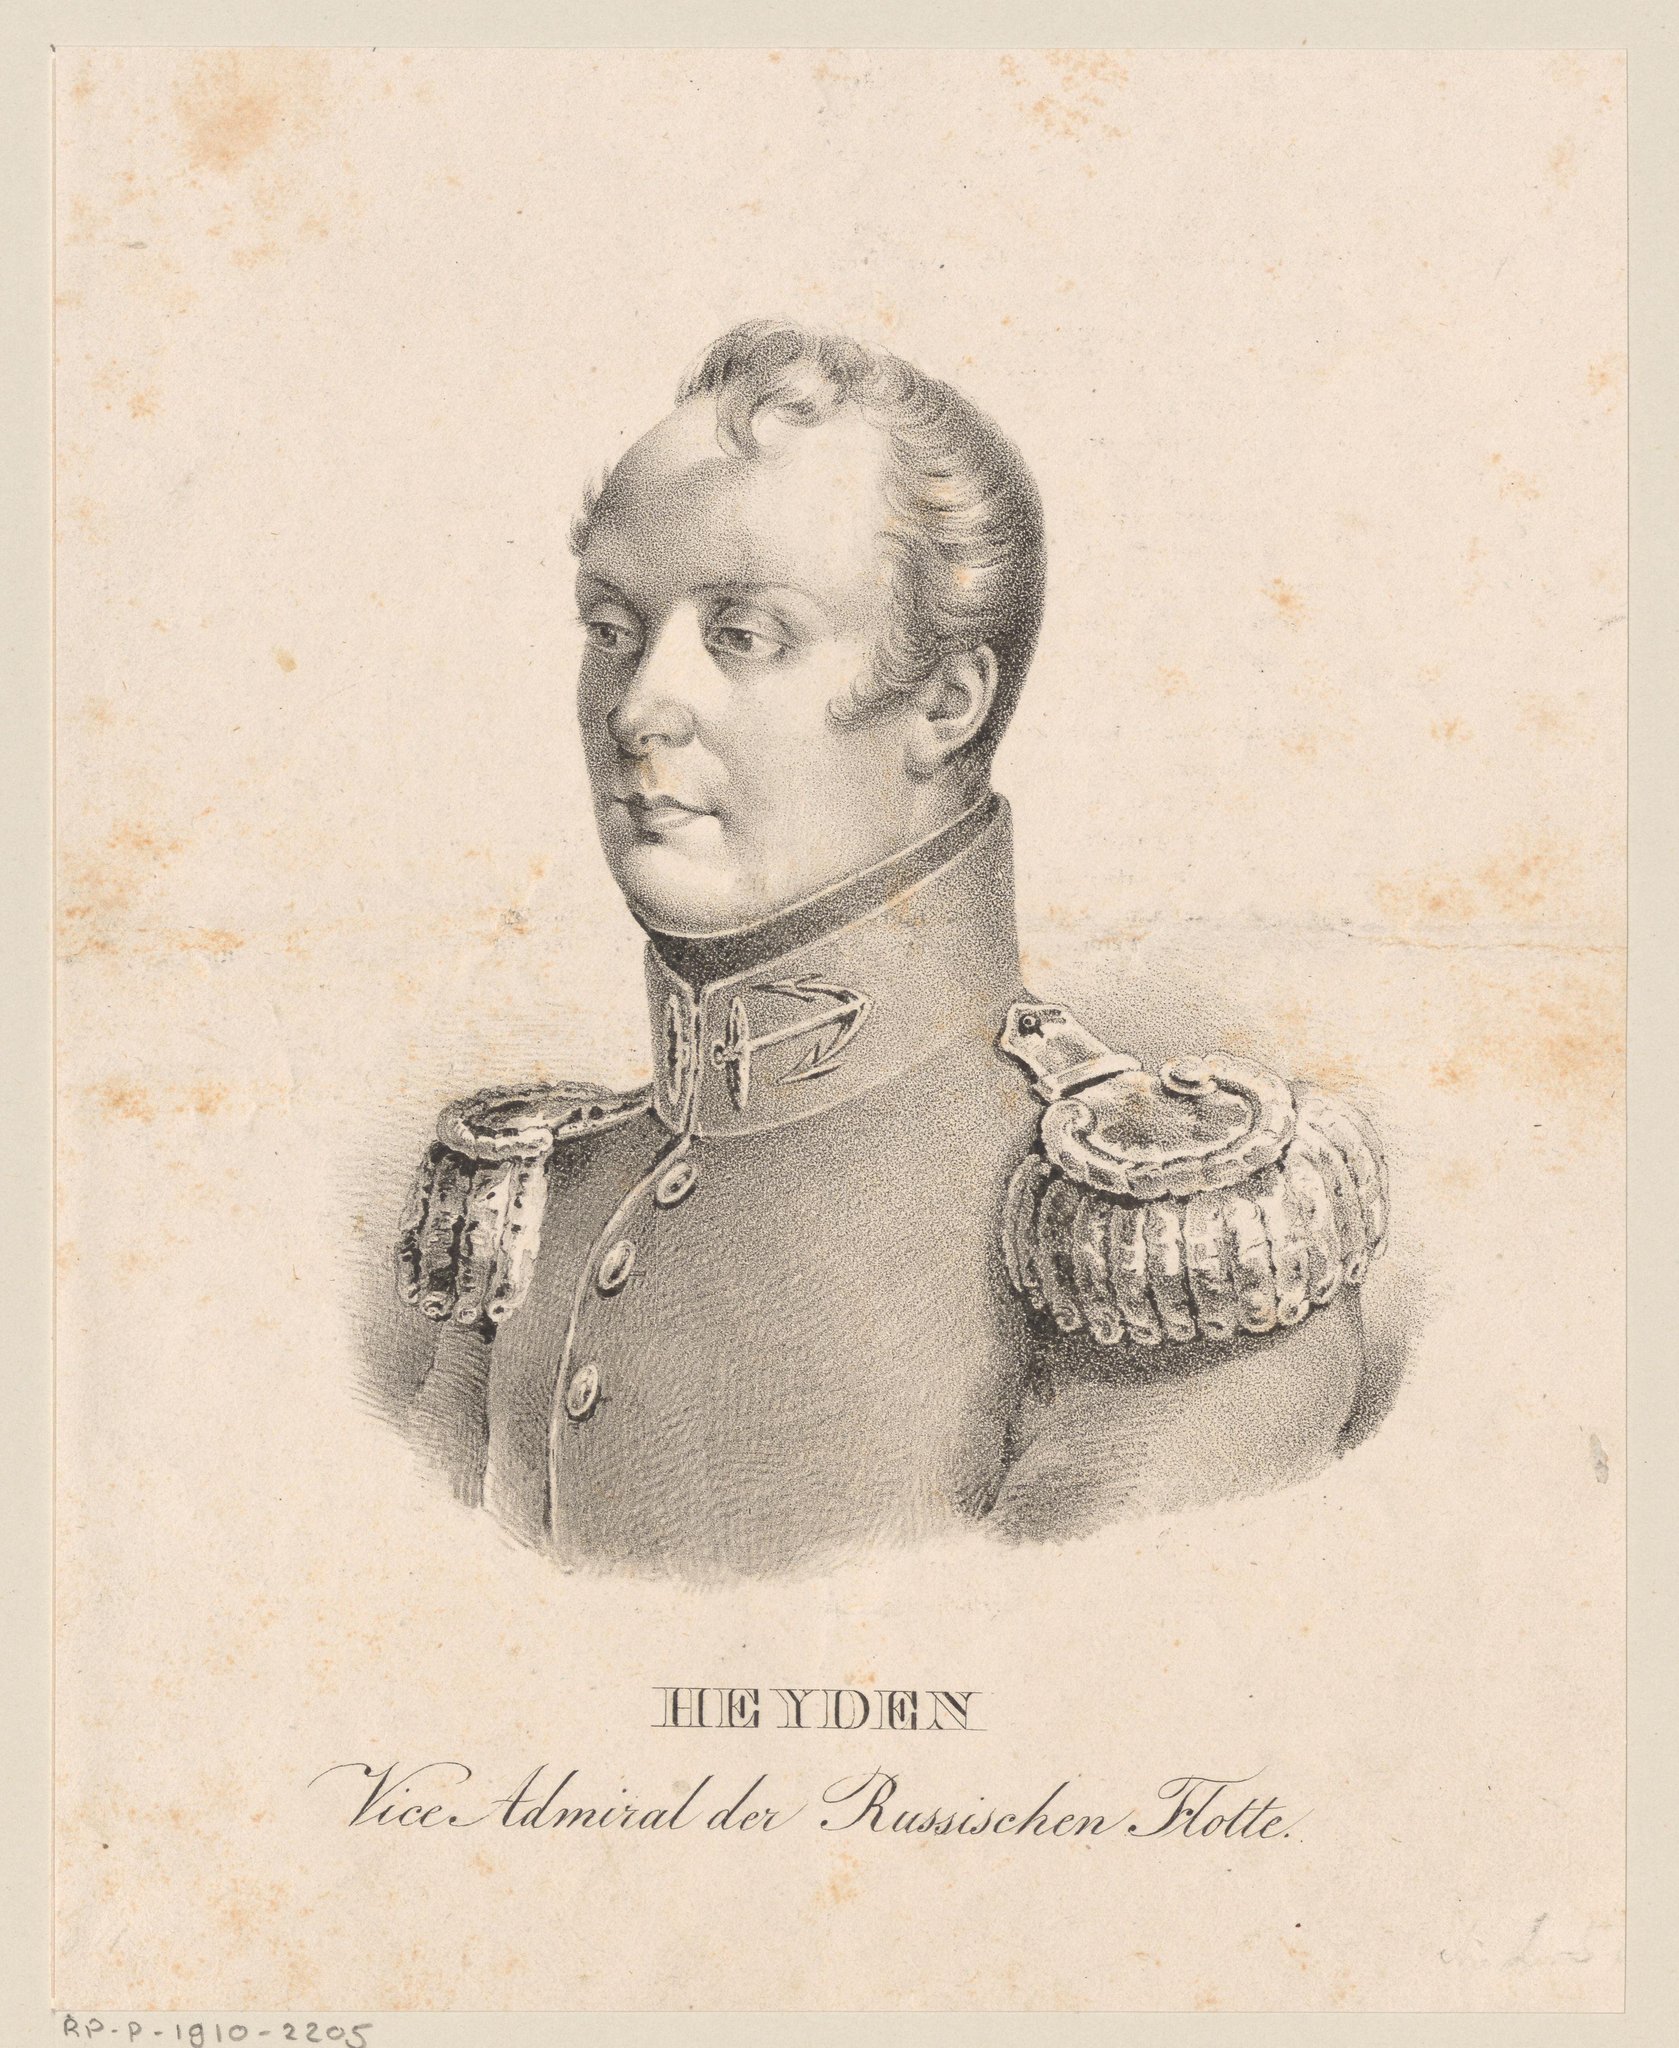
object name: print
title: Portret van Lodewijk van Heiden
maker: Anonymous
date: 1827-1849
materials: paper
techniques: lithograph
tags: the hague, historical persons, commander-in-chief, admiral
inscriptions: collector's mark: Lugt 2228